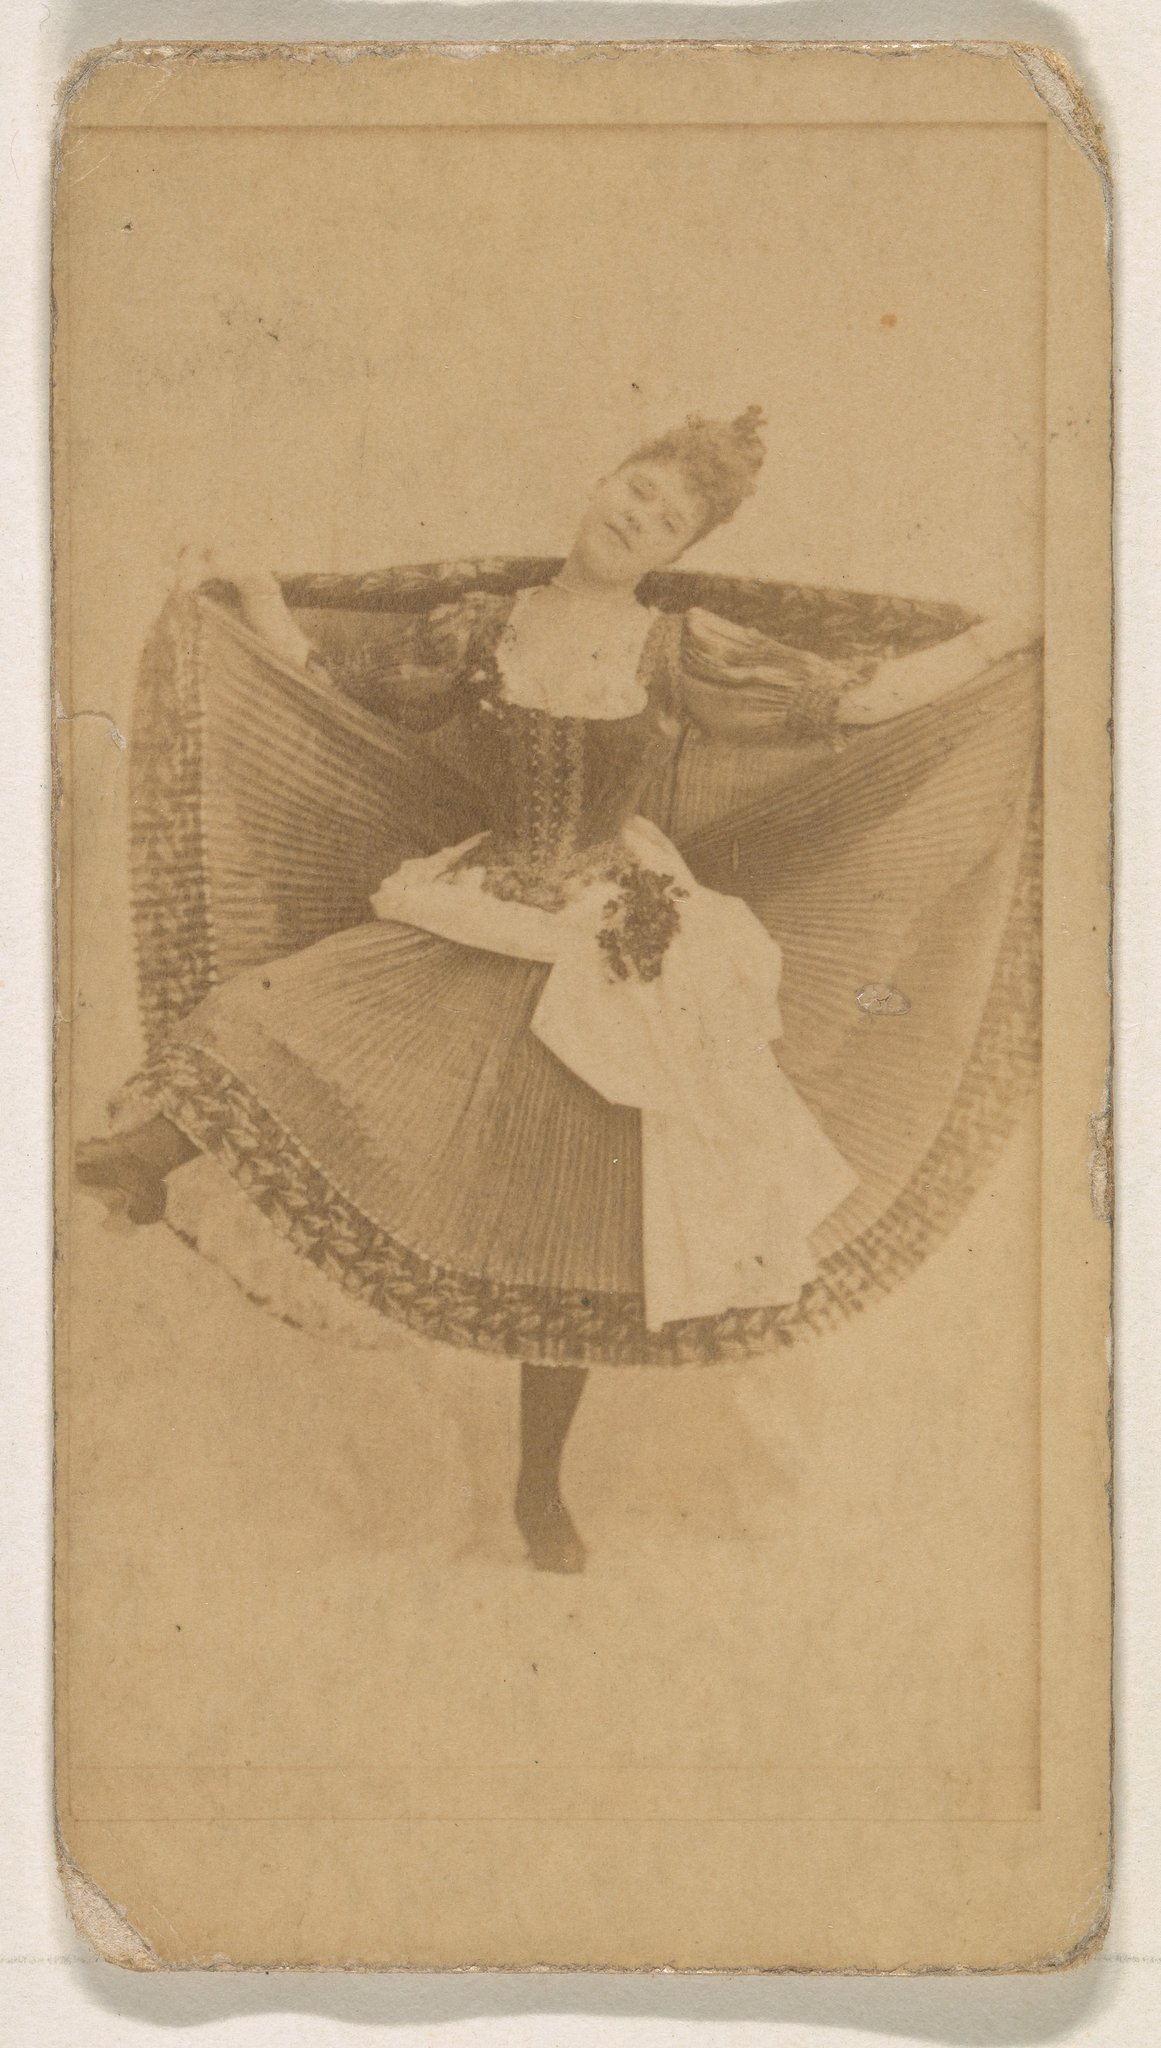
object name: photograph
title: Dancer holding skirt, from the Actresses series (N245) issued by Kinney Brothers to promote Sweet Caporal Cigarettes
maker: kinney brothers tobacco company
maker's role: publisher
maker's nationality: american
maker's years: 1869-2011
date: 1890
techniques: albumen silver print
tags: portraits,women,actresses